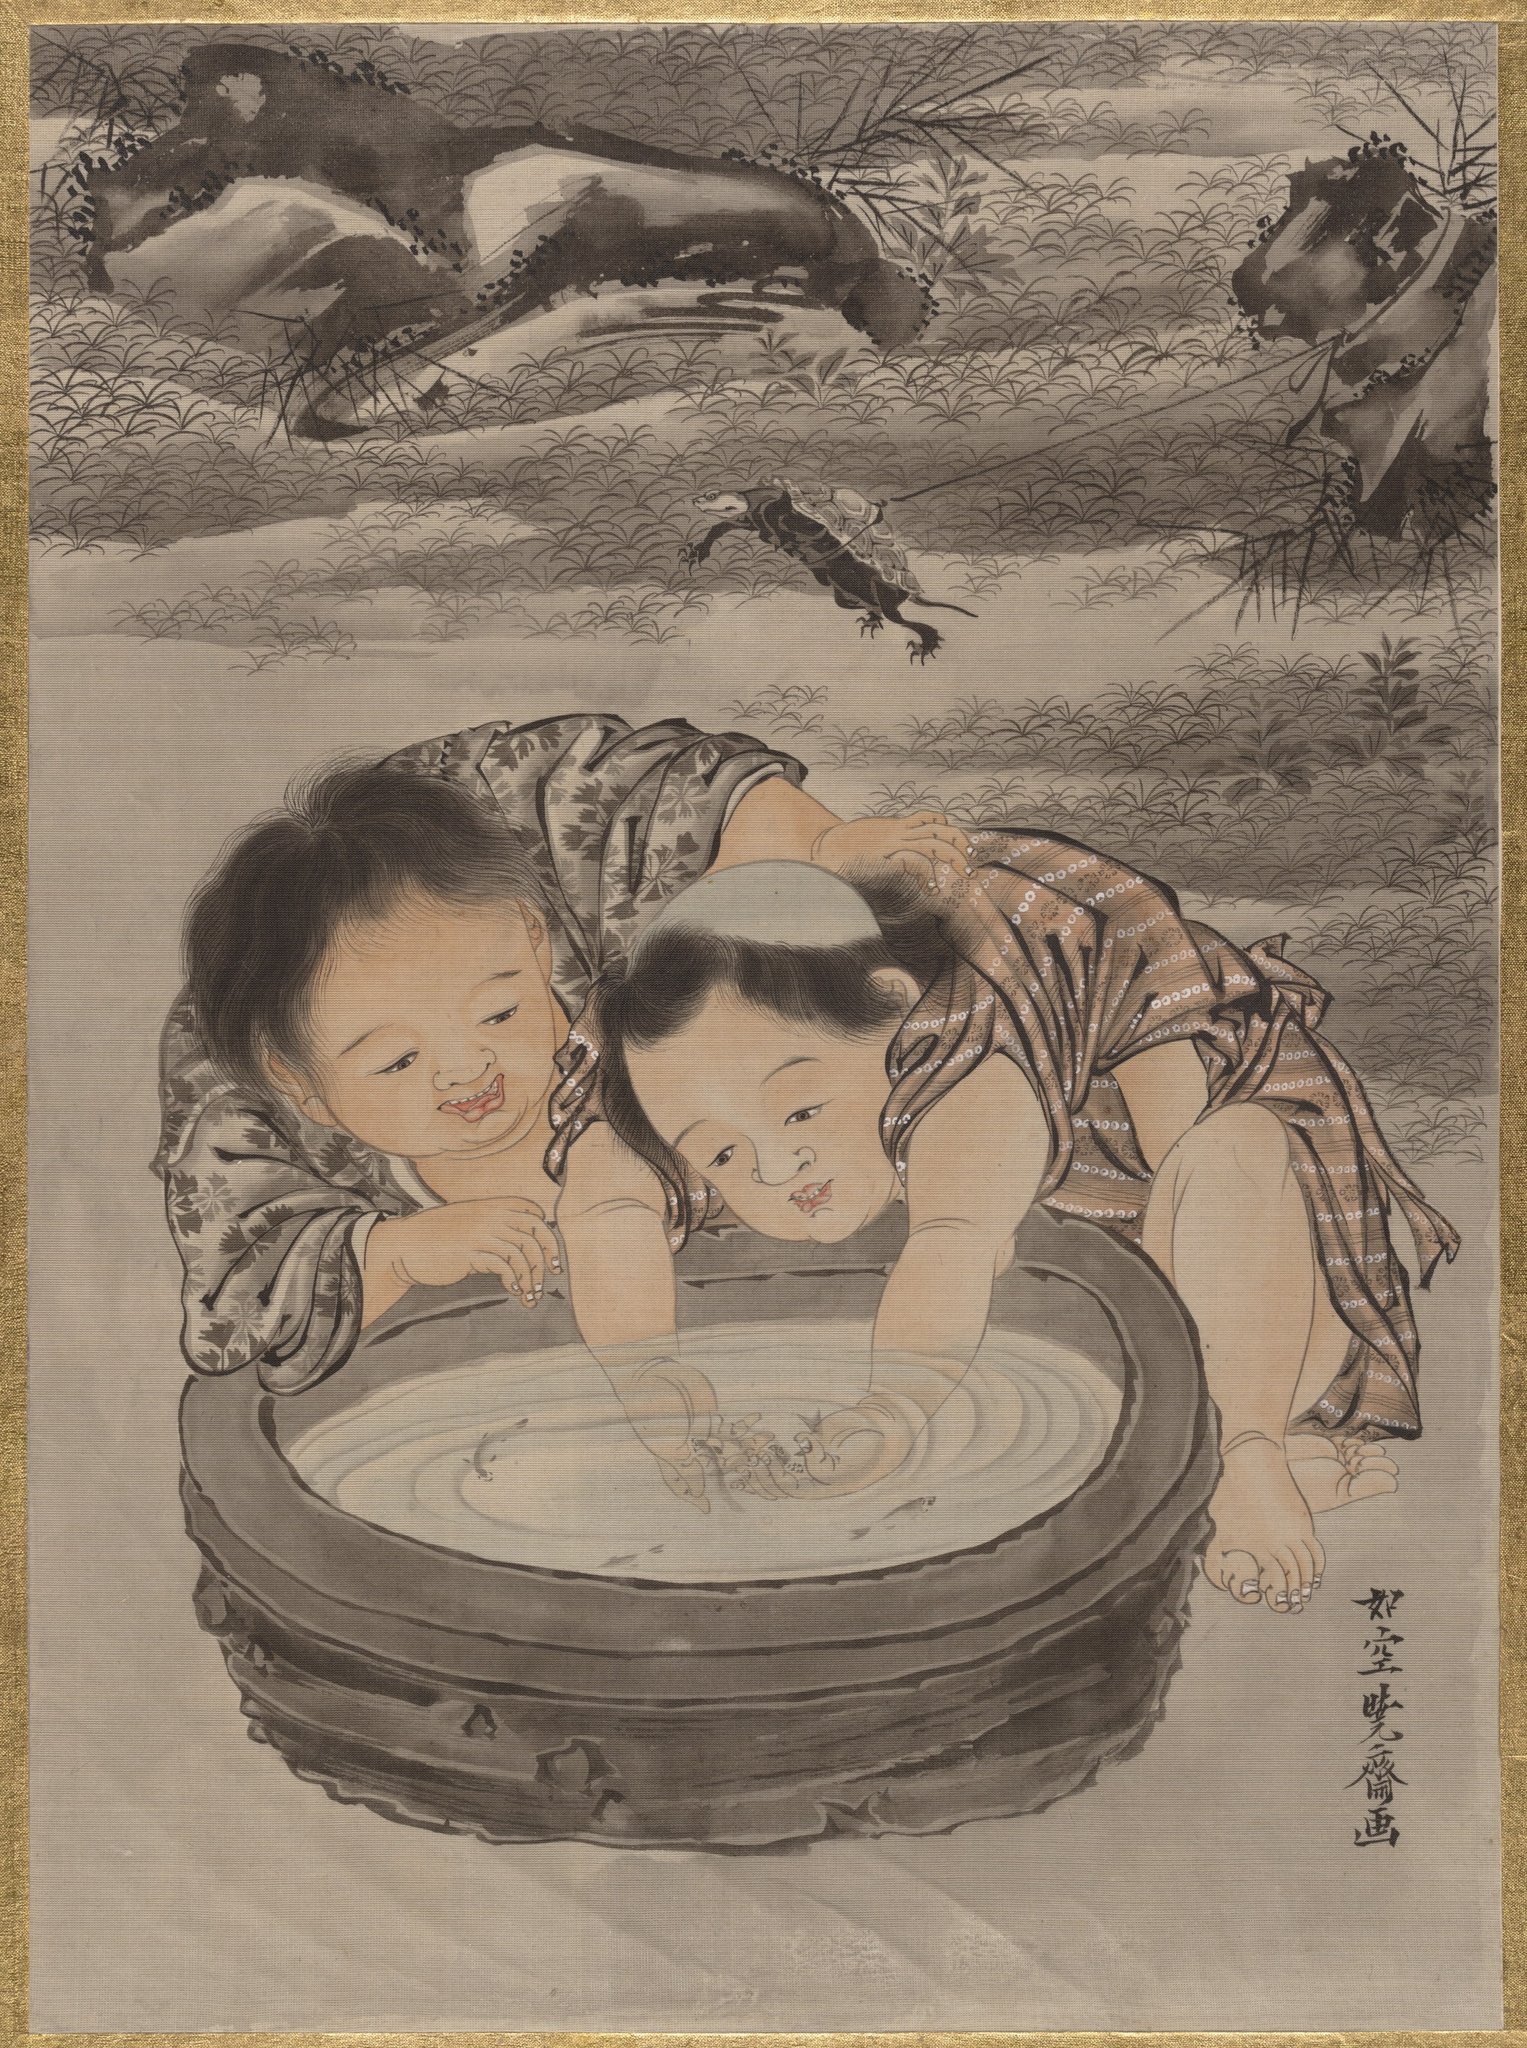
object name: album leaf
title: Two Children Playing with Goldfish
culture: japanese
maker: kawanabe kyōsai 河鍋暁斎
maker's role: artist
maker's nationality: japanese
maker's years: 1831-1889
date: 1887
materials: ink, silk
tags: boys,fish